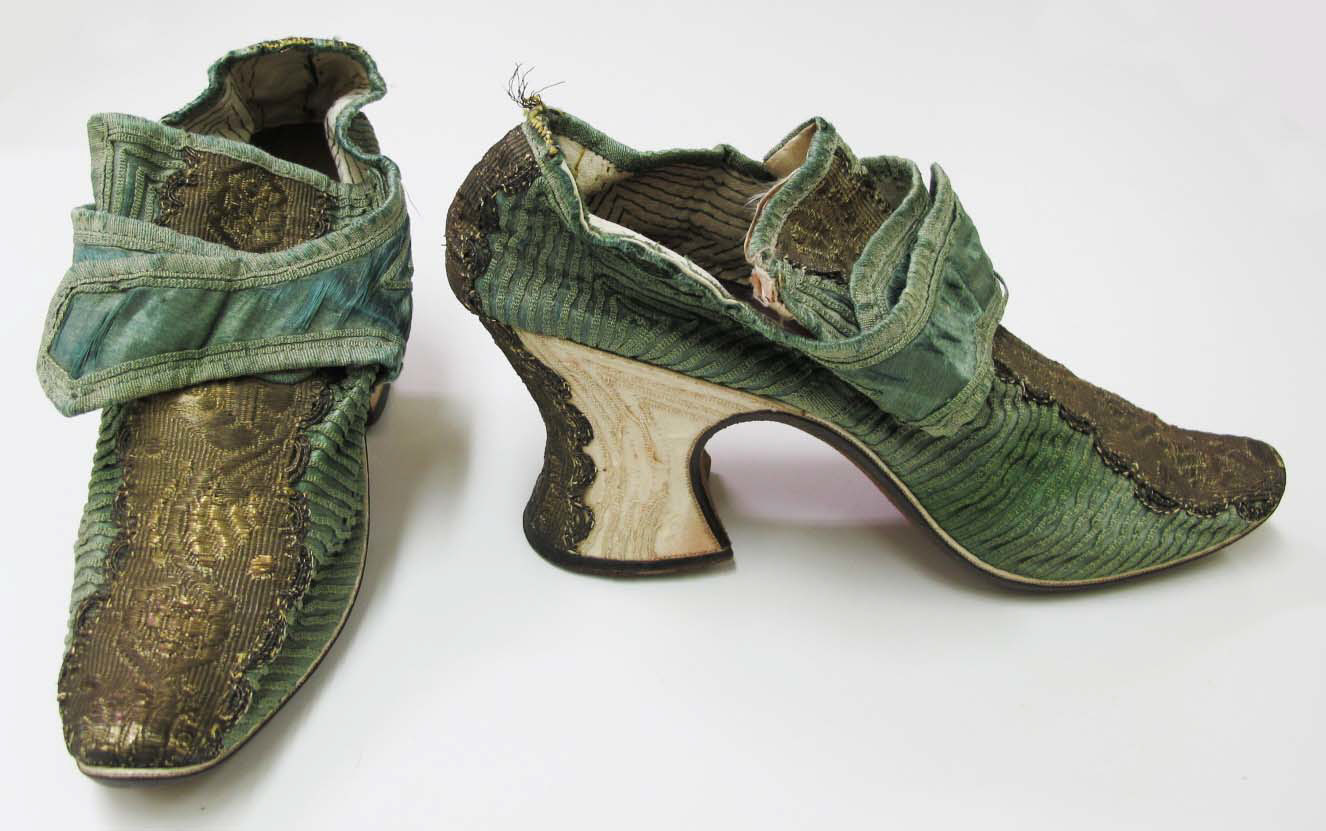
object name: shoe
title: Shoes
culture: european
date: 1701-1733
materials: leather, silk